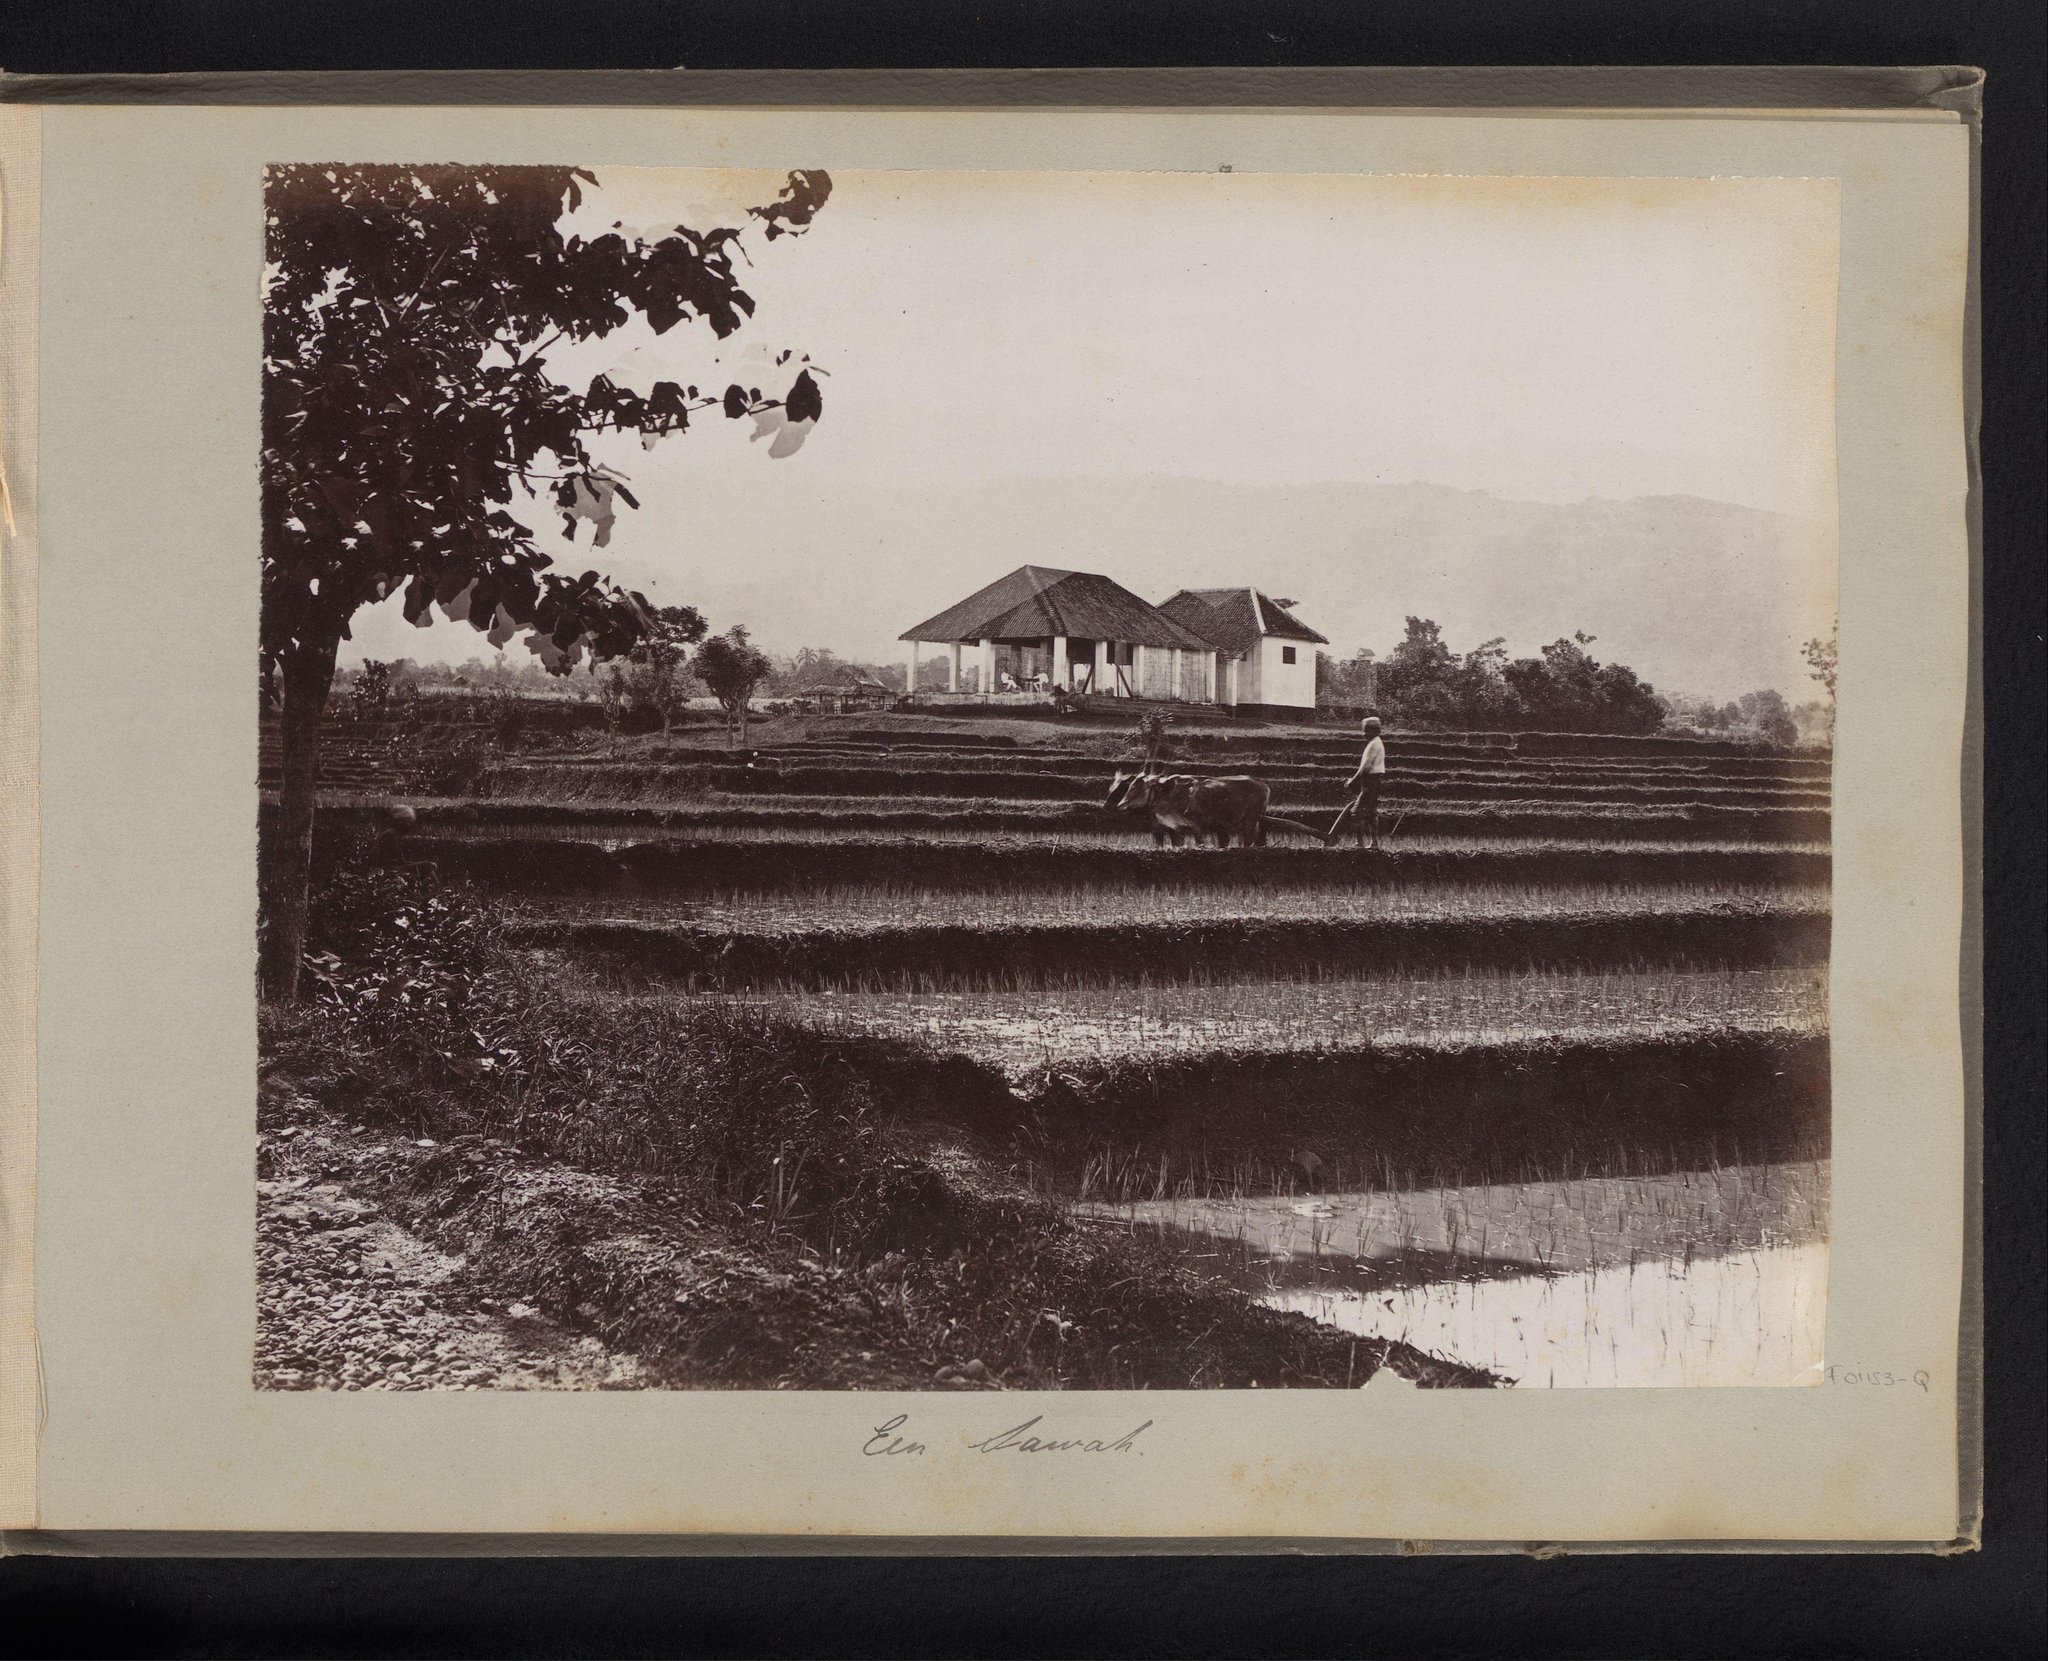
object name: photograph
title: Sawah met landbouwer en toeziende Hollanders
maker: Anonymous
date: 1890-1900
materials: photographic support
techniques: albumen print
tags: farmers, sawahs, rice paddies, indonesia